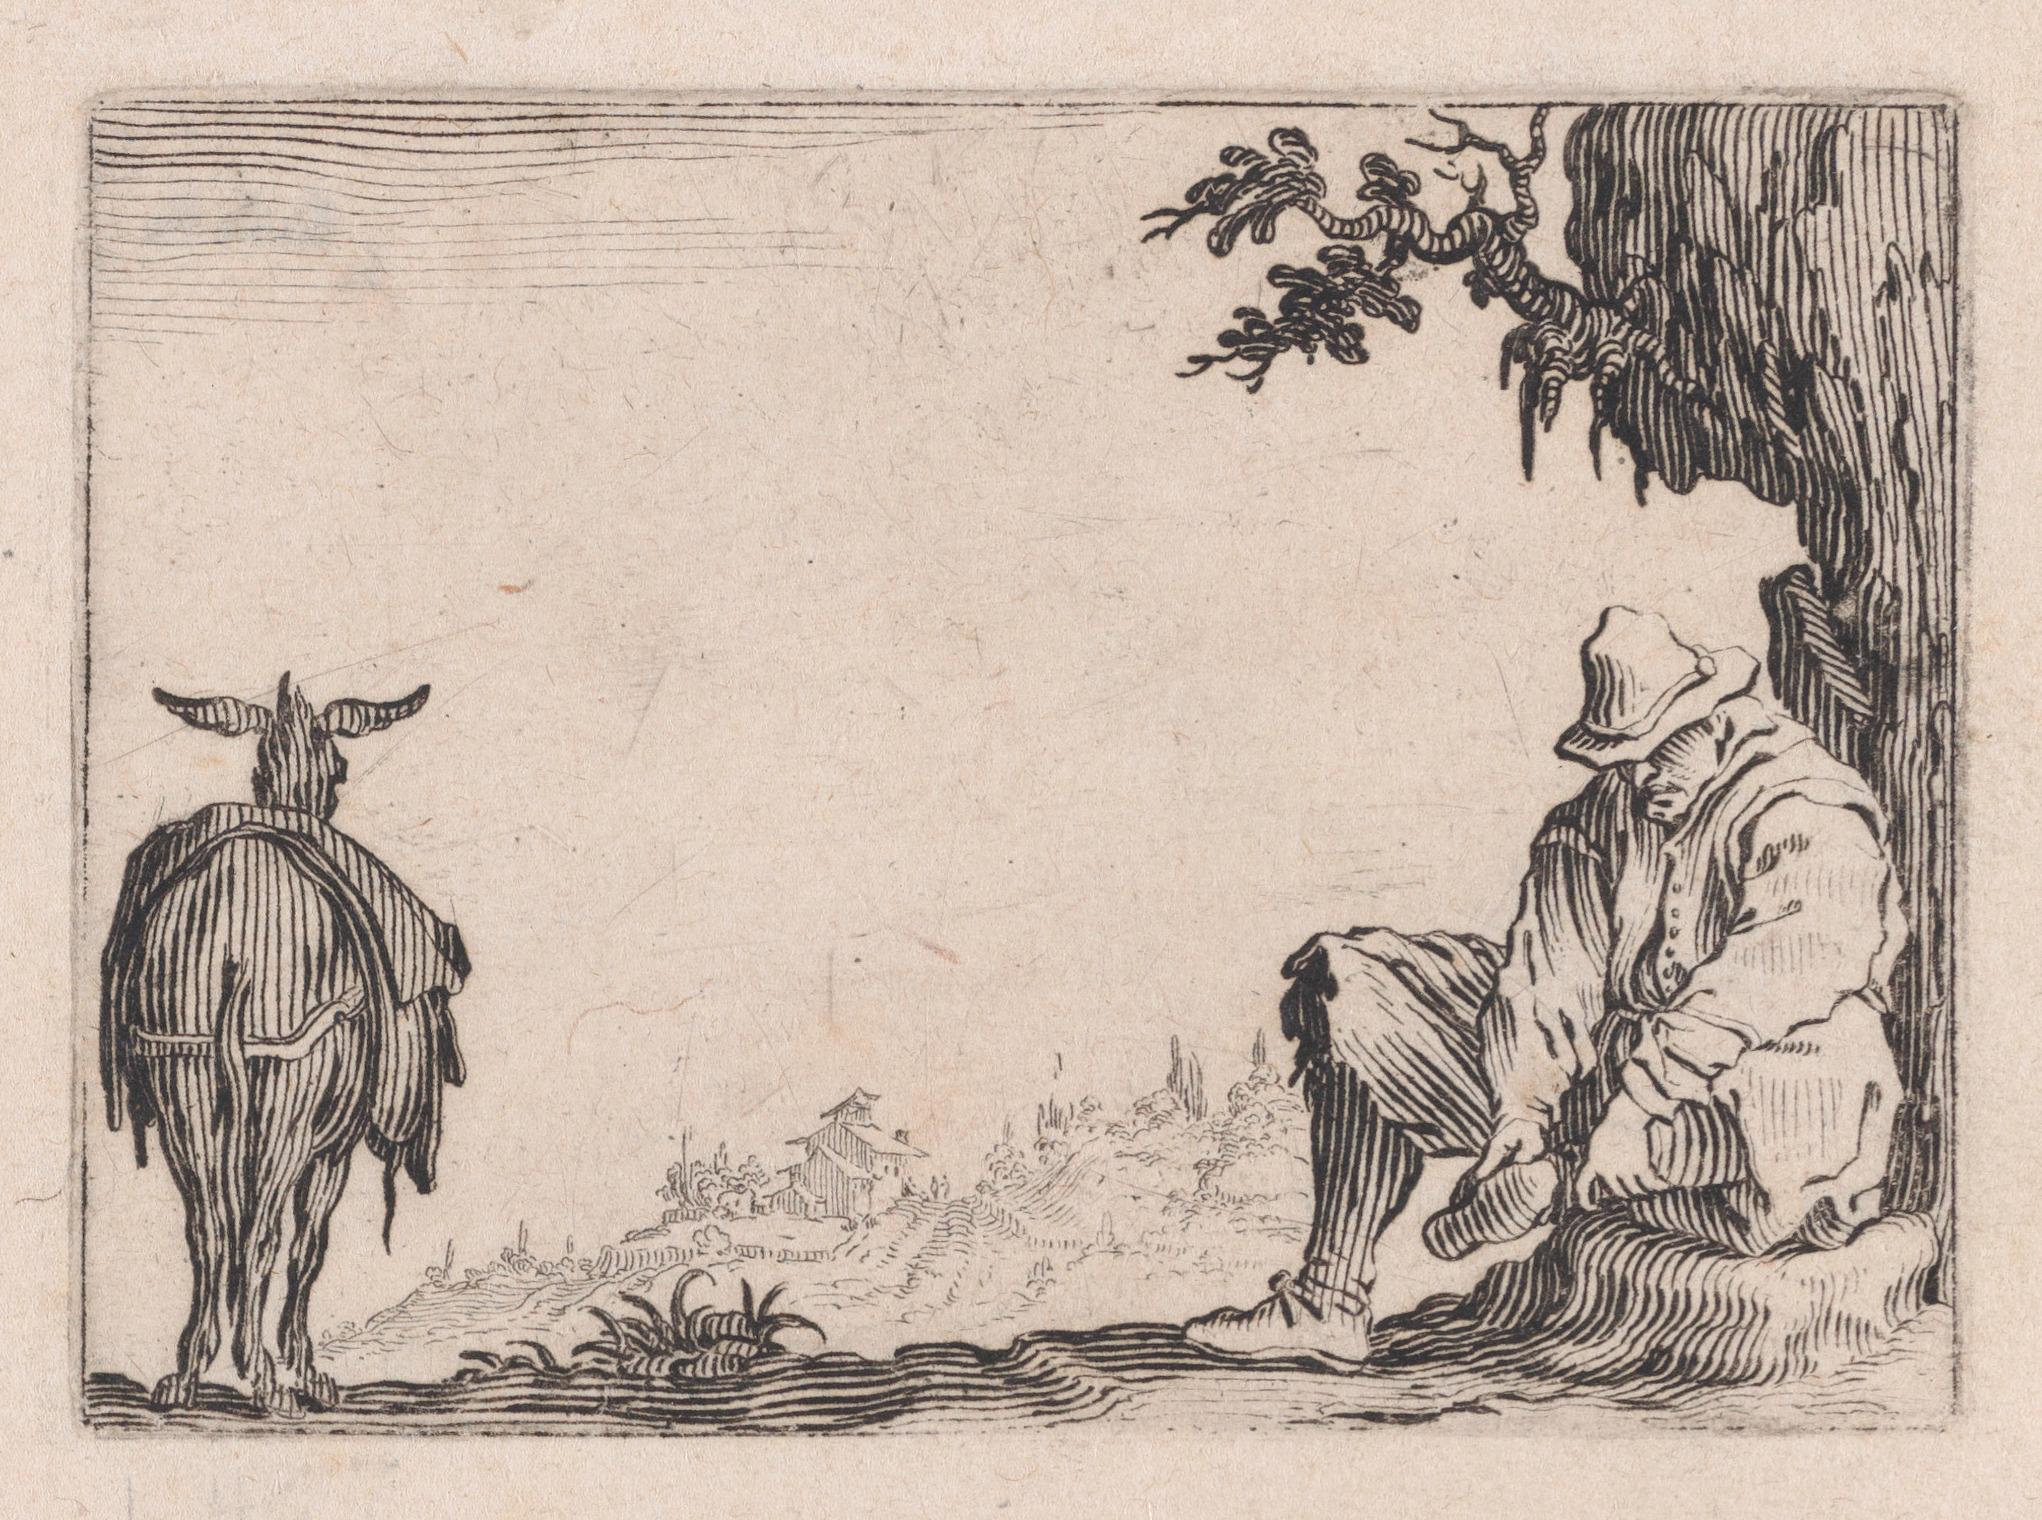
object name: print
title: Le Paysan se Déchaussant (The Peasant Removing his Shoes), from "Les Caprices" Series B, The Nancy Set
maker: jacques callot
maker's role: artist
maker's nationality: french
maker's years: 1592-1635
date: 1617-1620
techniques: etching